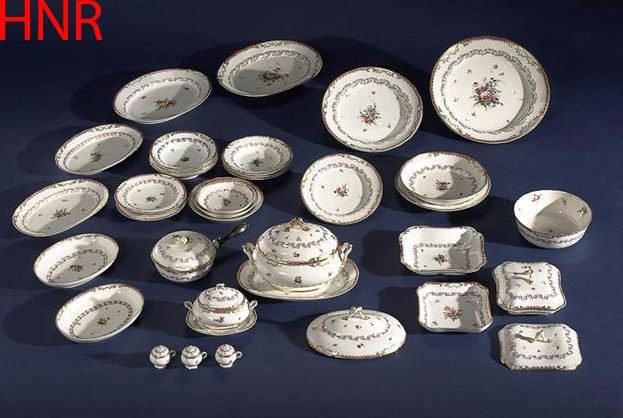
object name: dish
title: Bak of schaal, rond, met deksel en houten steel, behorend bij een servies met geslingerd lintmotief met bladertakken, bloemboeketten en gestrooide bloemtakken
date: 1780-1820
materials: porcelain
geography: loosdrecht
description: Bak of schaal, rond, met deksel, behorend bij een servies van porselein, versierd met een geslingerd lintmotief in paars en goud met groene bladertakken, bloemboeketten en gestrooide bloemtakken. Randen lichtgegolfd met decoratie in goud met paars bladmotief waartussen groen gekruist bladmotief. Dekselknop in de vorm van een vrucht met steel en bladeren in goud. Gemerkt: M.O.L. en Amstel. Opmerking: bak door midden gebroken/gebarsten.